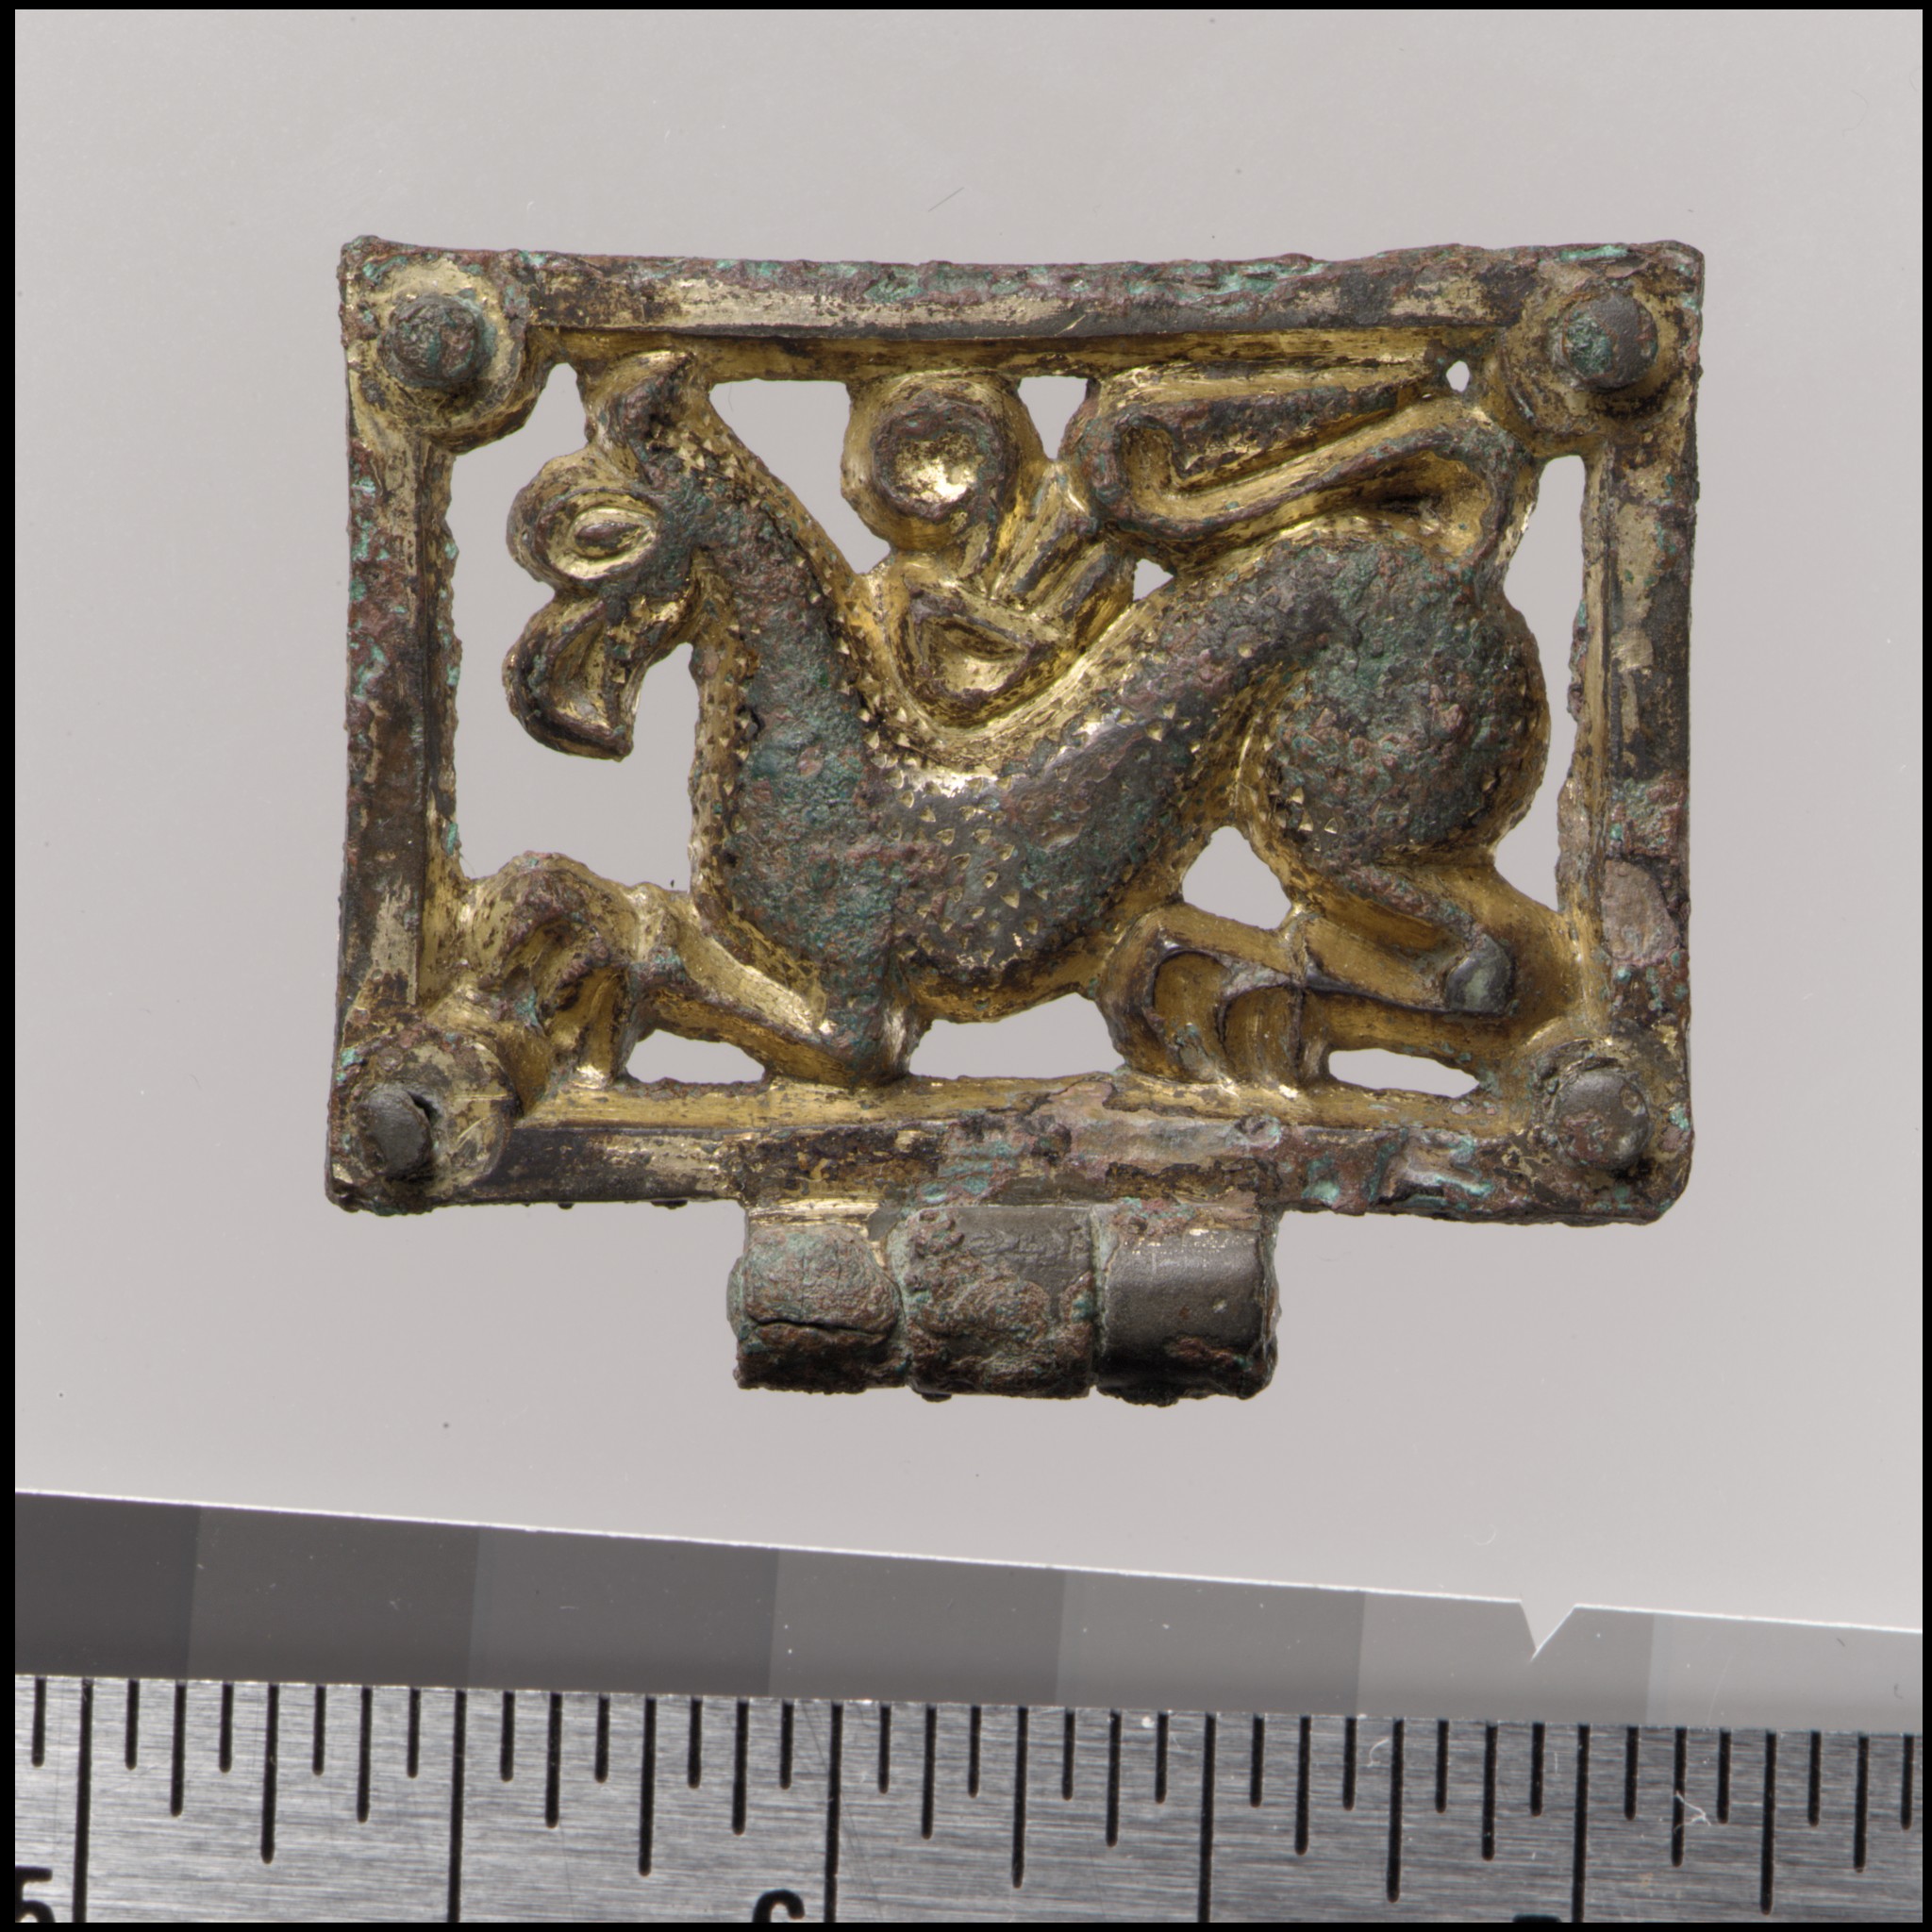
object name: belt fitting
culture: avar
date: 701-900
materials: bronze, gilt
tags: griffins